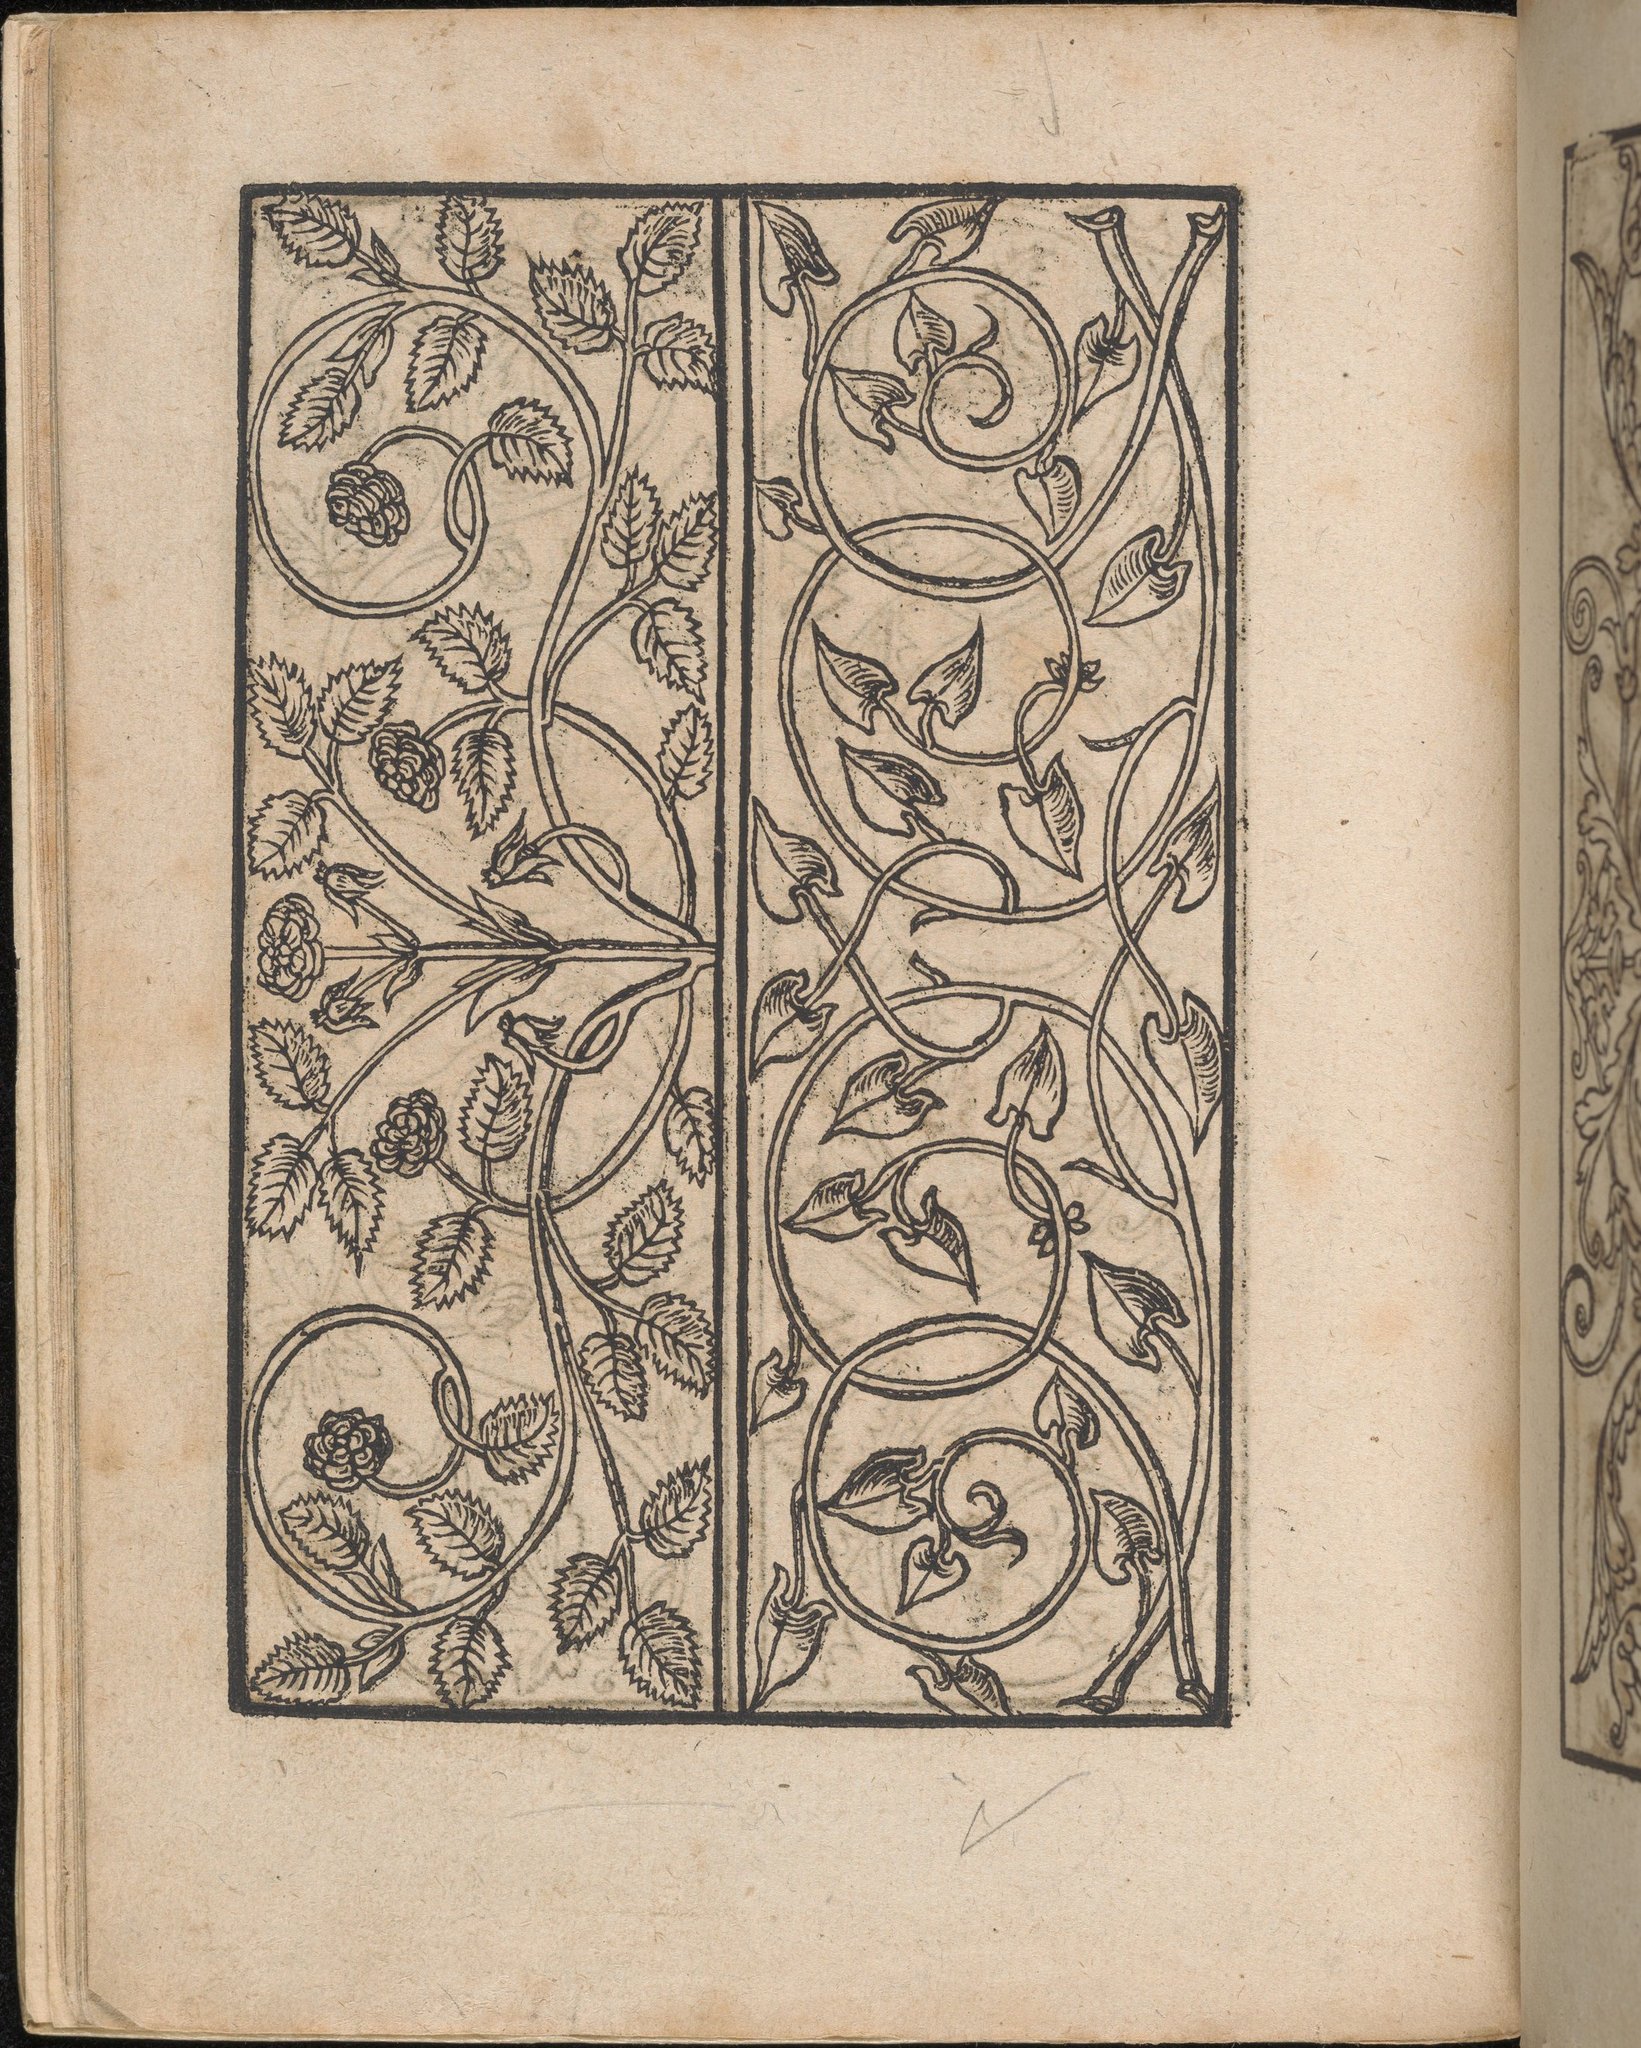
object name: book print ornament architecture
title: Ein new Modelbuch..., page 10 (verso)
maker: johann schönsperger the younger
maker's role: publisher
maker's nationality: german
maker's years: 1490-1550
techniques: woodcut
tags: flowers